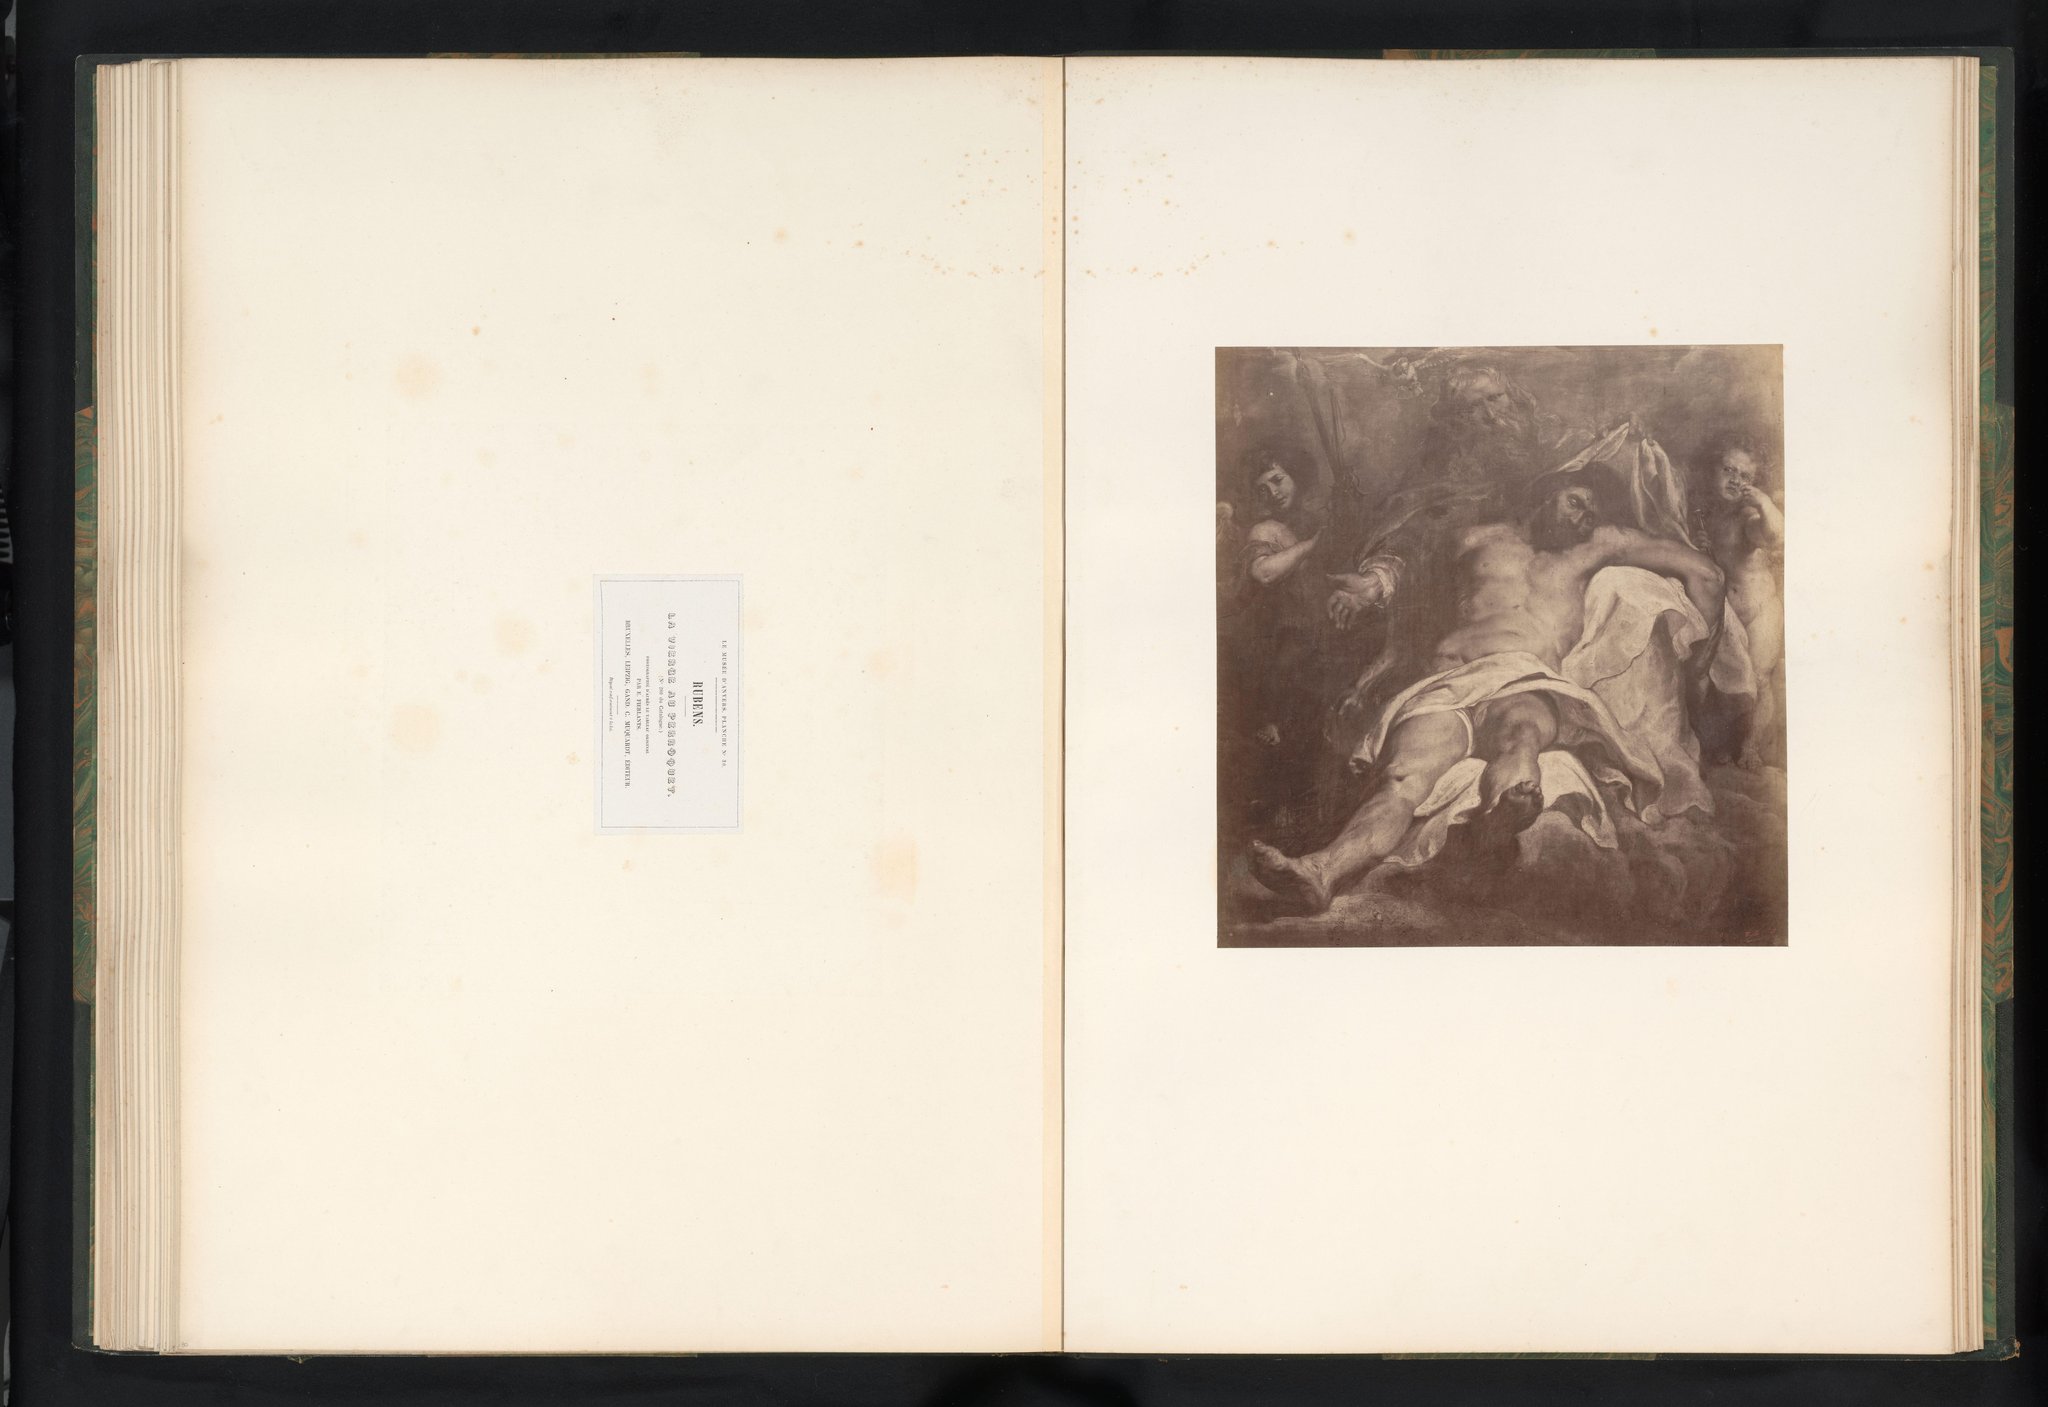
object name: page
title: Fotoreproductie van de Heilige Drie-eenheid door Peter Paul Rubens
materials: photographic support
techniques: albumen print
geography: brussels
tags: god the father holding the crucified or dead christ